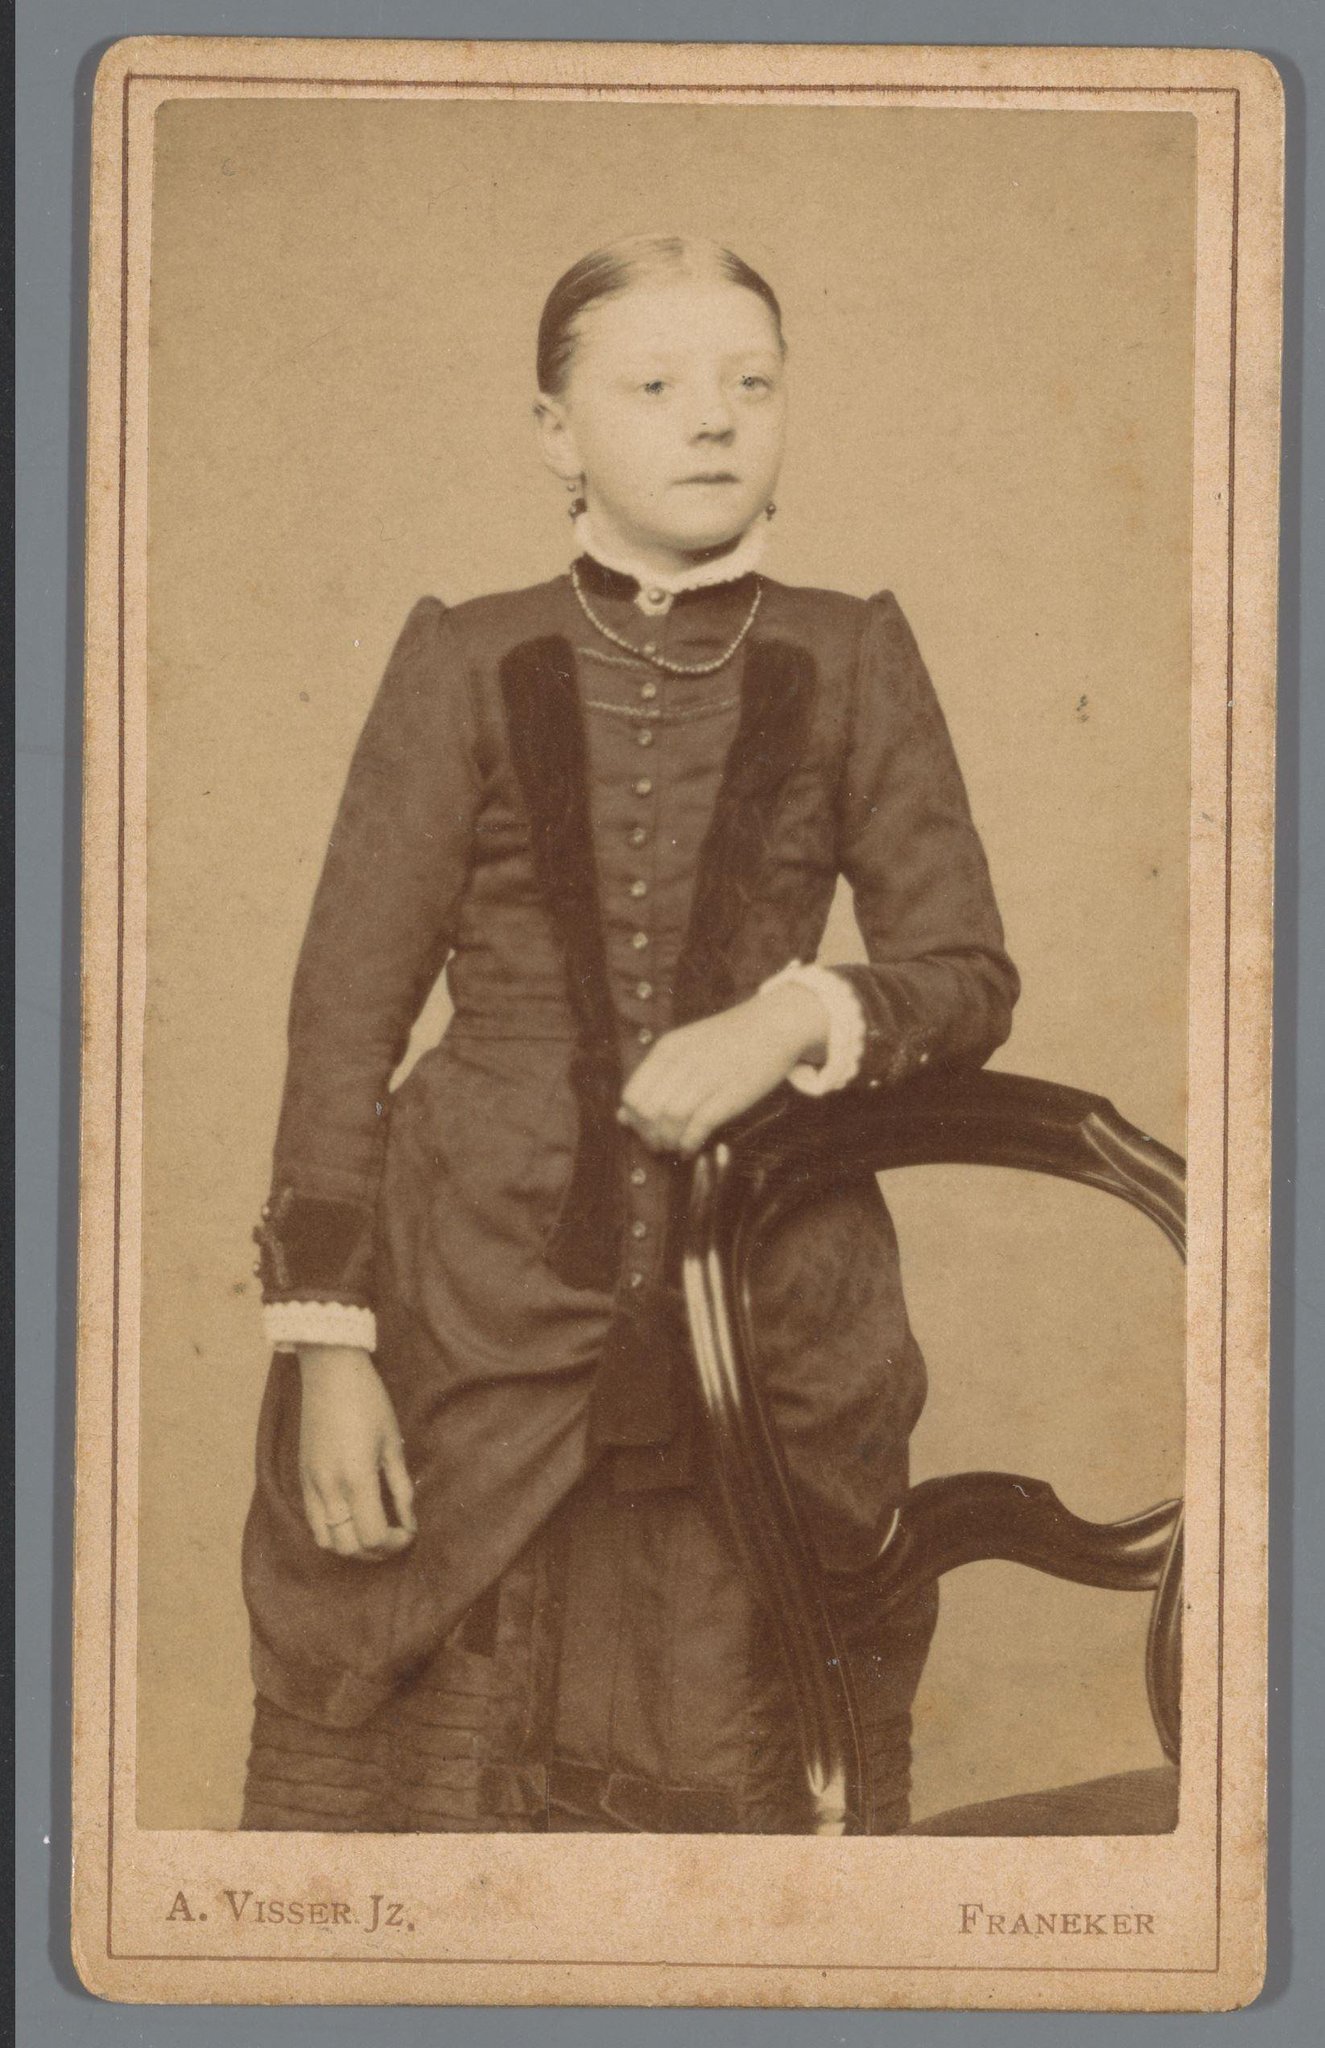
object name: photograph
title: Portret van Anna Mulder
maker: a. visser jzn.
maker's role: fotograaf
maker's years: 1847-1926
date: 1812-1885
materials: cardboard, paper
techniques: albumen print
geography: franeker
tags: historical persons, girl (child between toddler and youth)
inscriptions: inscription: ‘December 1885’, inscription: ‘Photographie Artistique/ van/ A. Visser Jz/ Plat TN 102./ Franeker./ Portretten kunnen op iedere groote/ nabesteld worden.’, inscription: ‘Anna Mulder/ geb. 17 Apr. '74 - Dec 1885’, inscription: ‘A. Visser Jz. Franeker’, monogram: ‘AVJz’